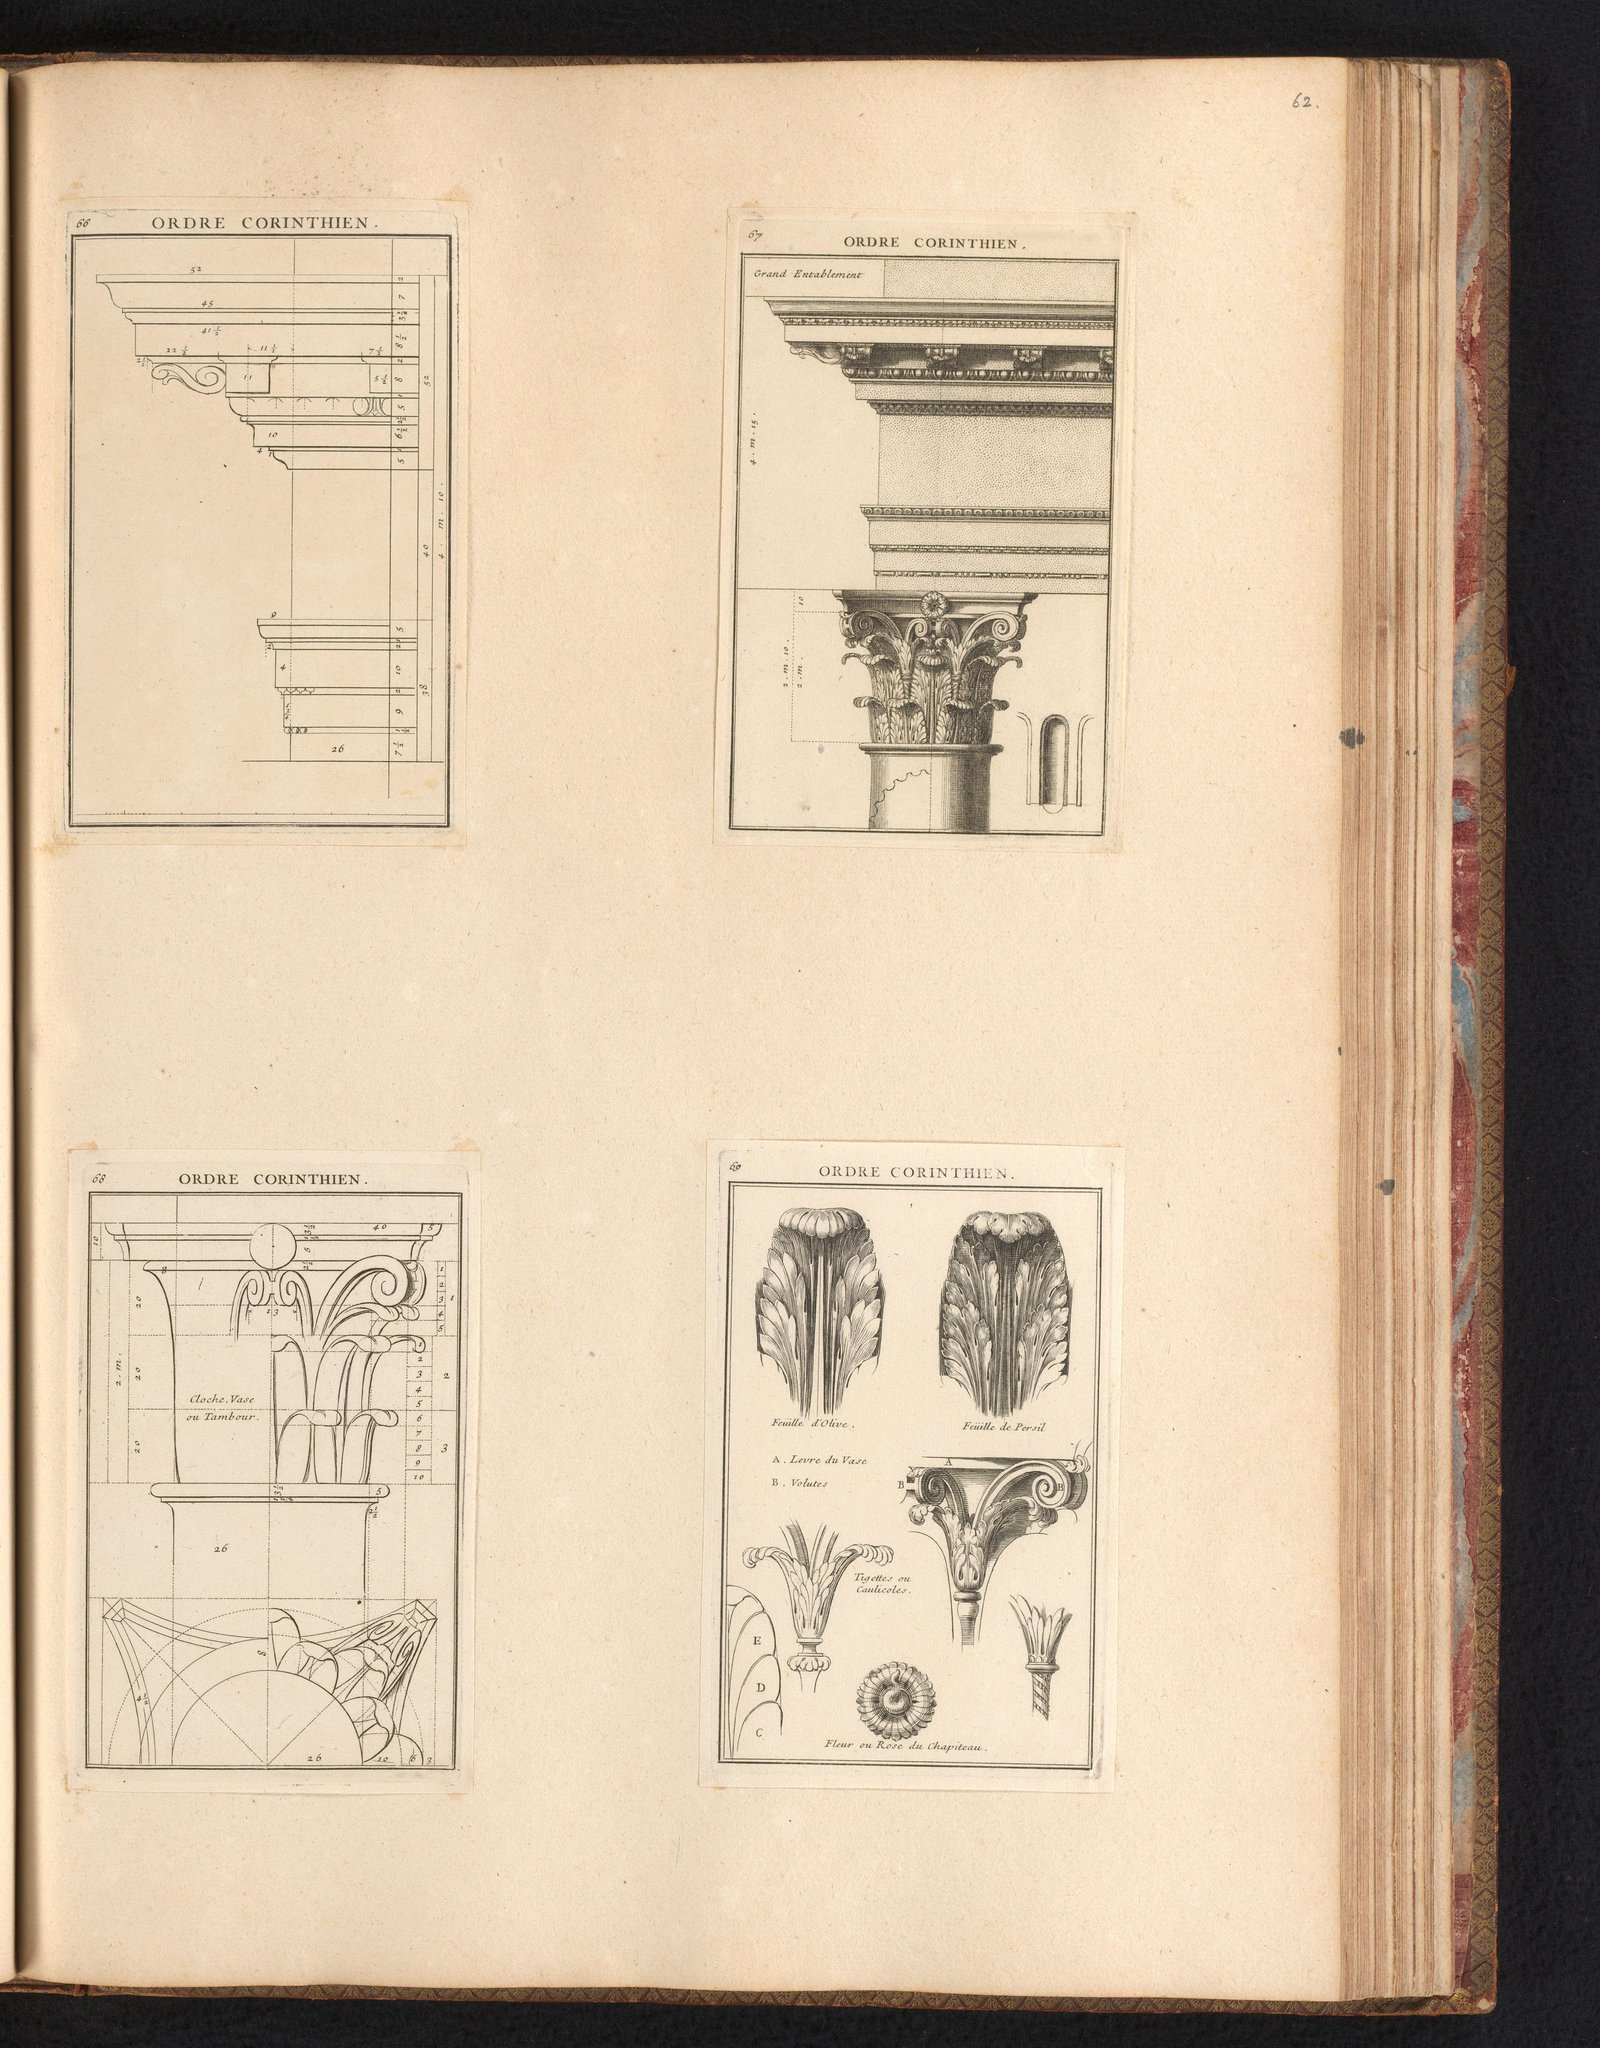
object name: album leaf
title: Zuilen van de Korinthische orde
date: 1714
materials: paper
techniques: etching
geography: paris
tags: corinthian order ~ architecture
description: Prenten uit: Leclerc, Sébastien (I). Traité d'architecture. Parijs: Pierre François Giffart, 1714.